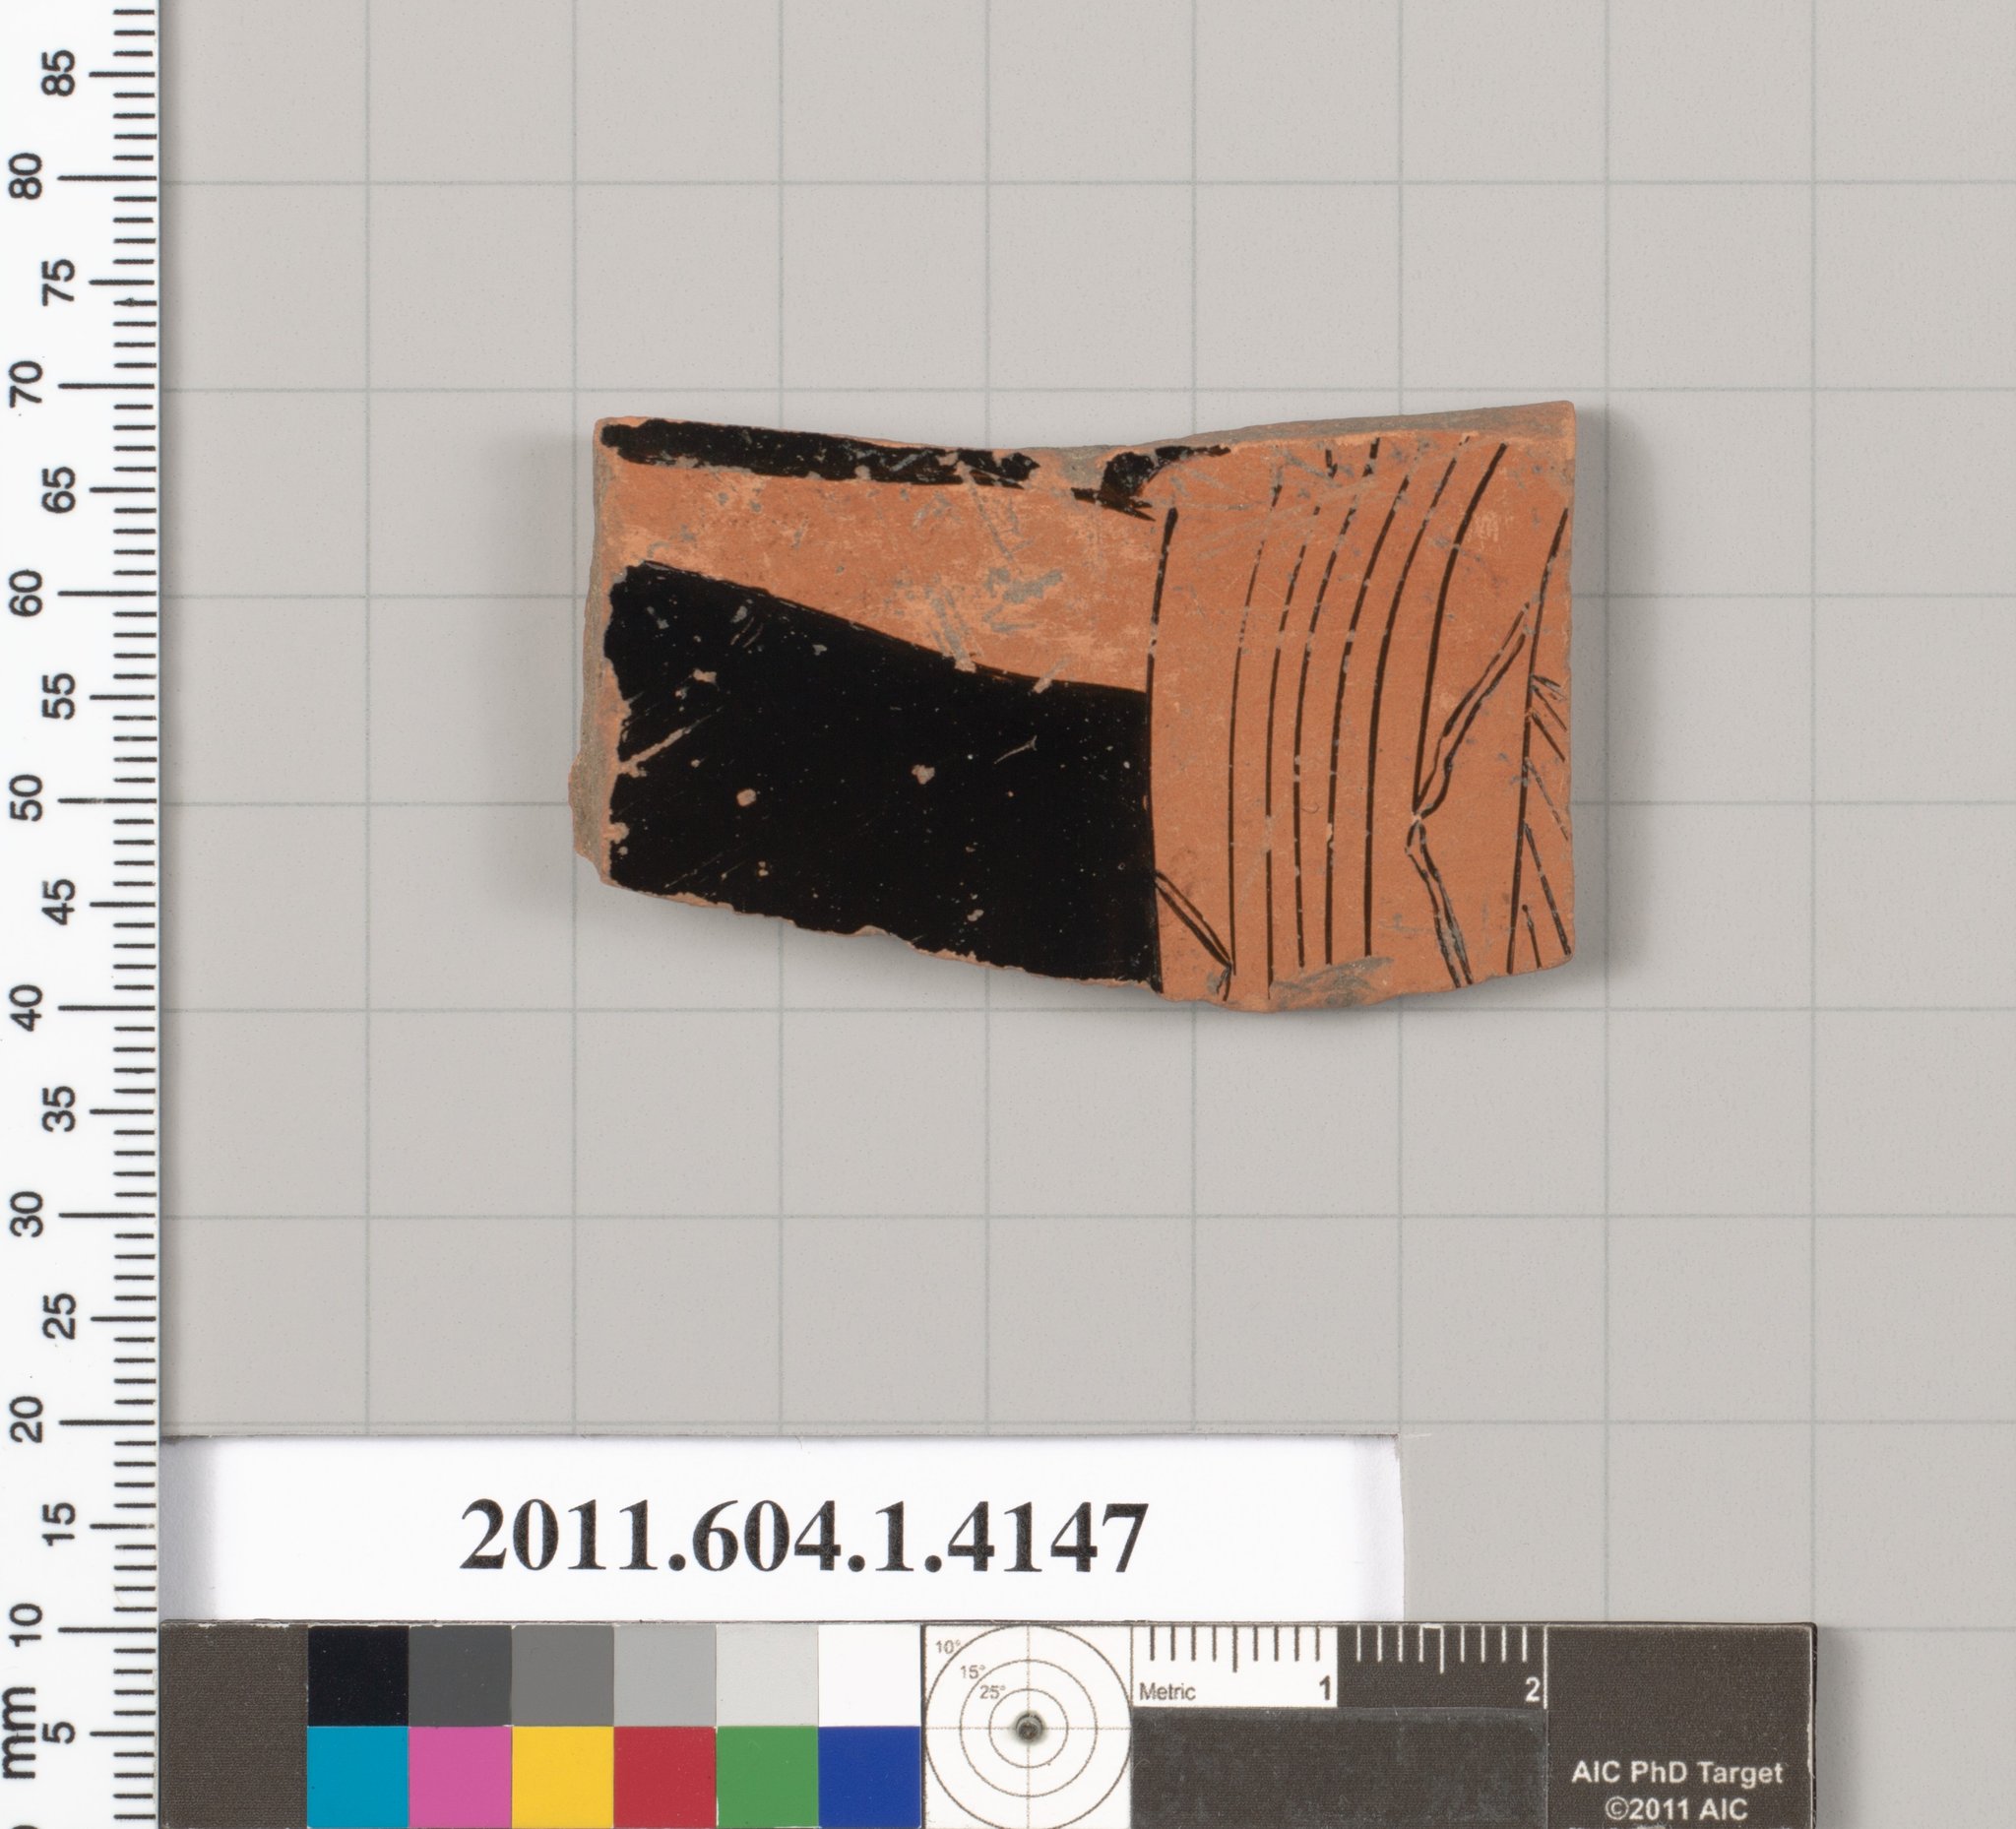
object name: kylix fragment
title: Terracotta fragment of a kylix (drinking cup)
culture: greek, attic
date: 480-470 BCE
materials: terracotta